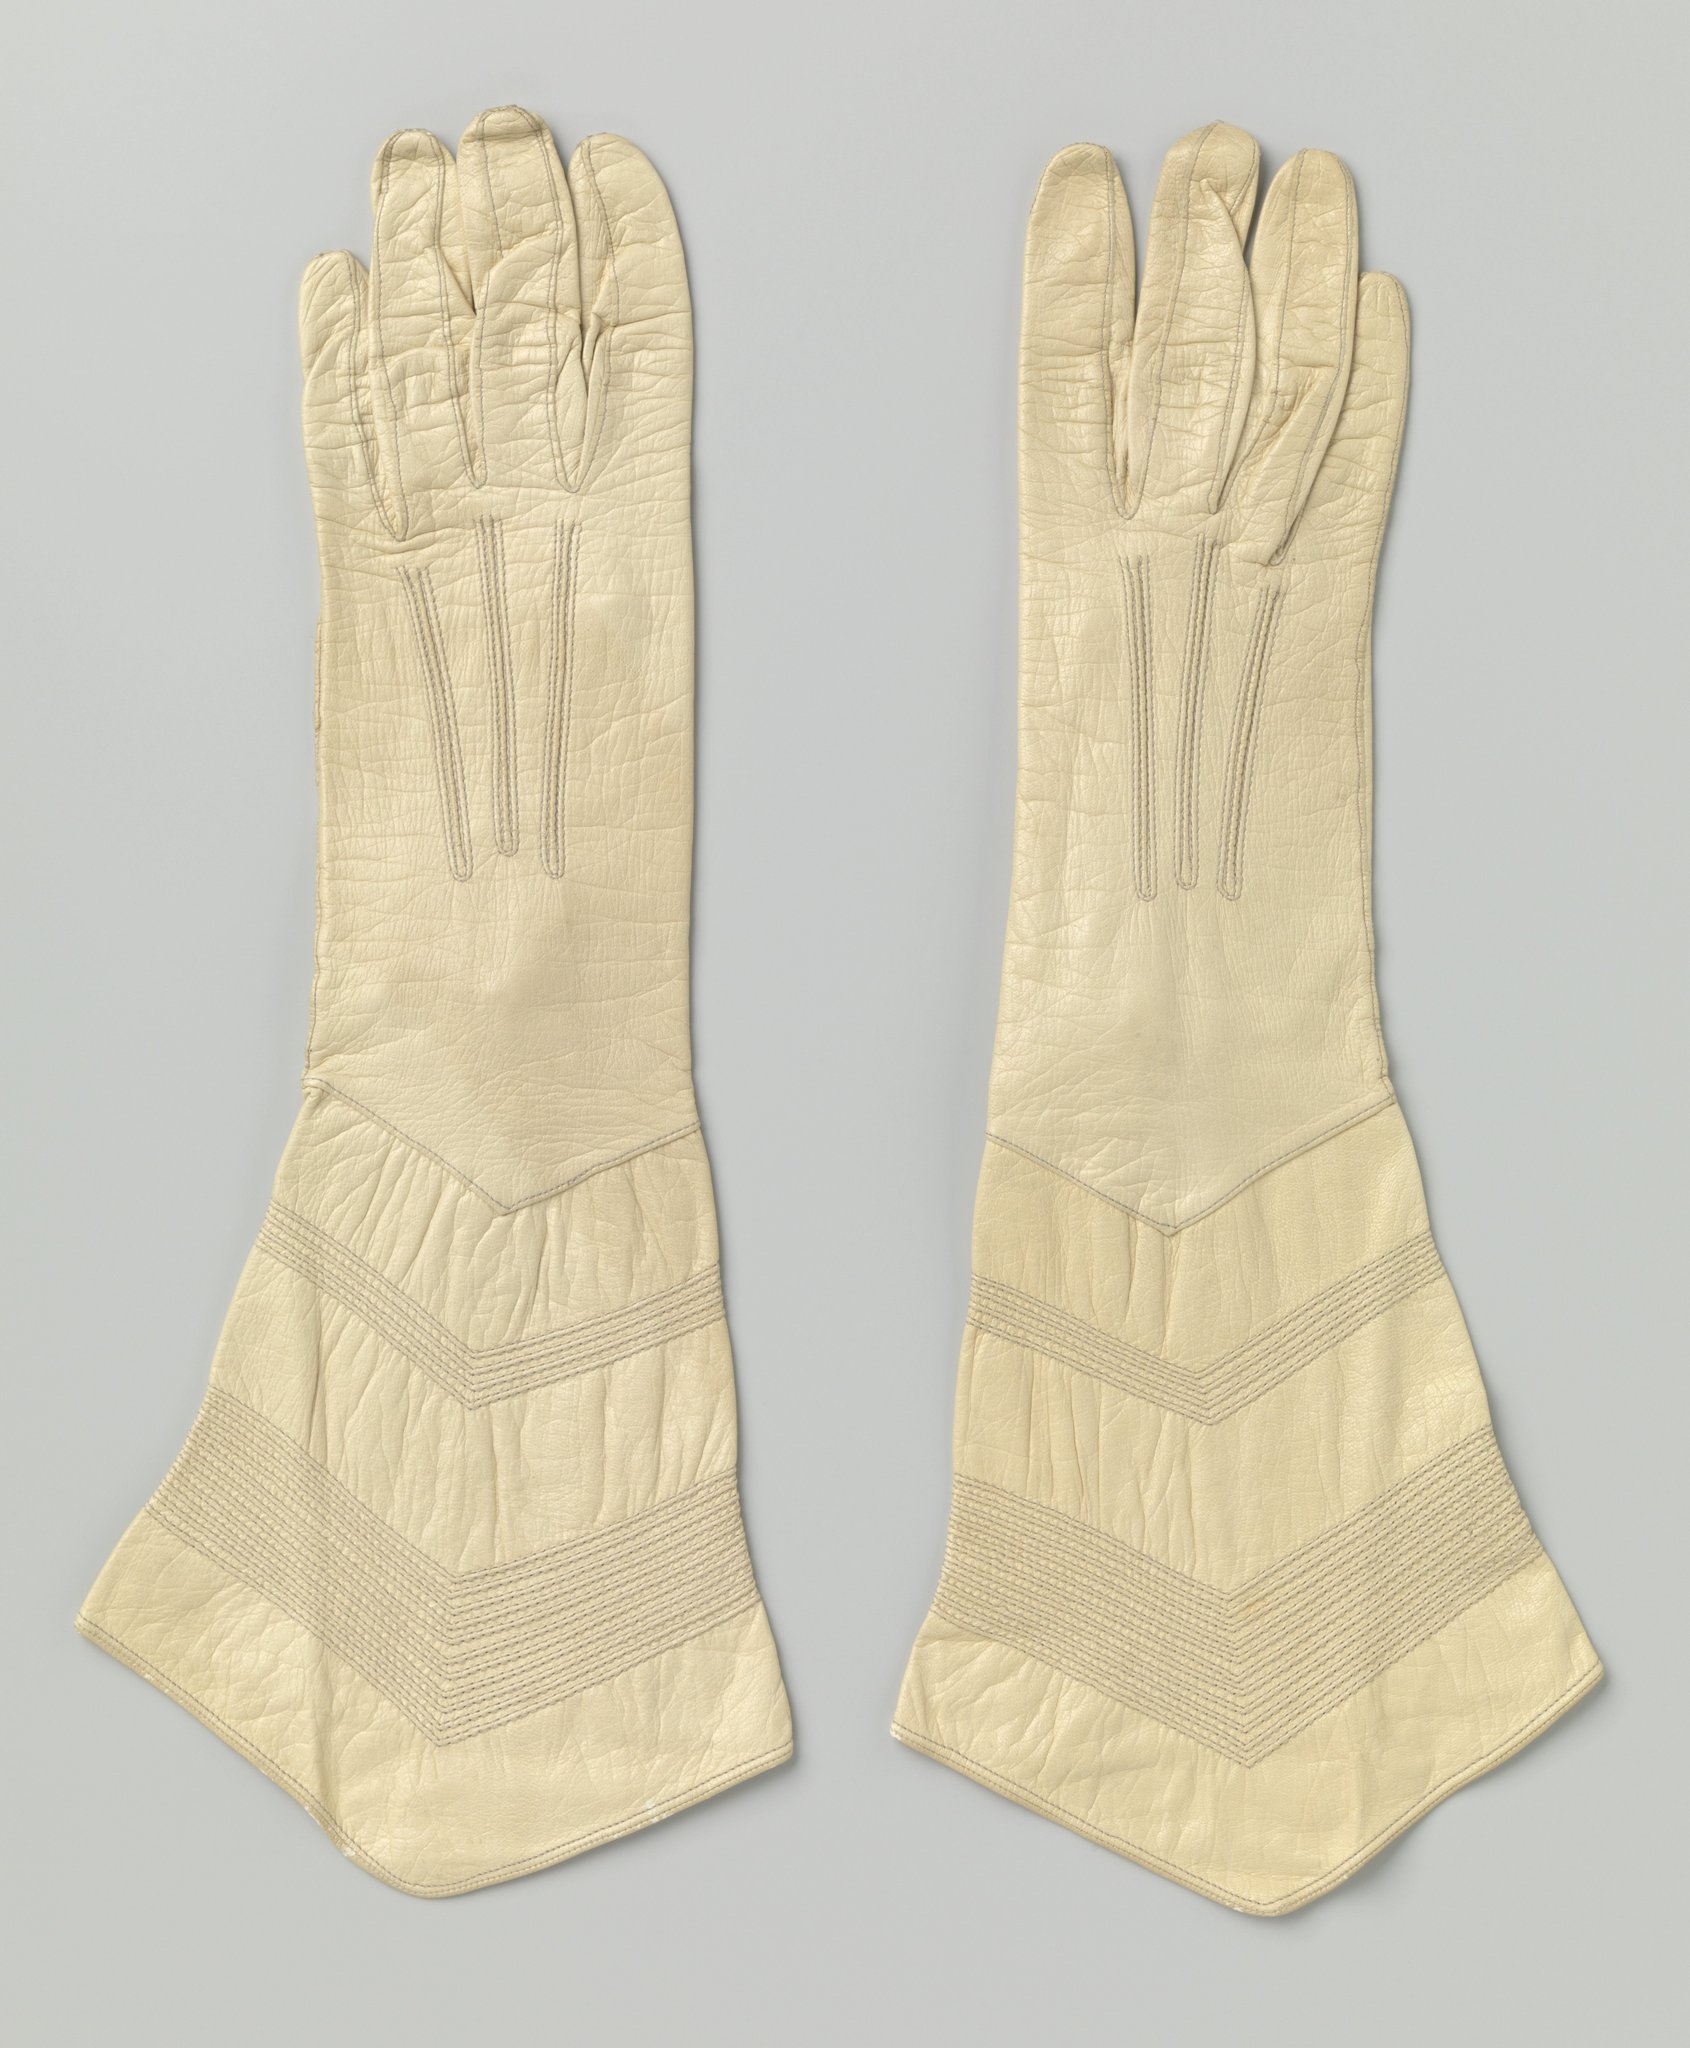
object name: glove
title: Pair of gloves with pointed cuffs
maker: m. laimböck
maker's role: modehuis, modewarenhuis, modewinkel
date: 1922-1930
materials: leather, mother of pearl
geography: amsterdam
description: Rechter handschoen van beige glacé-leer. Model: driekwartlang met kappen en middensplitten. Naden van de kappen in diepe punten gevormd en doorgestikt. Dikke parel als sluiting. Adres: binnenin gedrukt: 1. BILTON/V.S.PAT.SEPT.19.'22(?). 2. Gekroonde adelaar met banderol waarop M. LAIMBOCK/UITTYROL/AMSTERDAM/K.HOFLEVERANCIER (onduidelijk) en: MADE IN SAXONY. Saksen, voor fa. Laimböck Amsterdam. 1922-1930 (?).